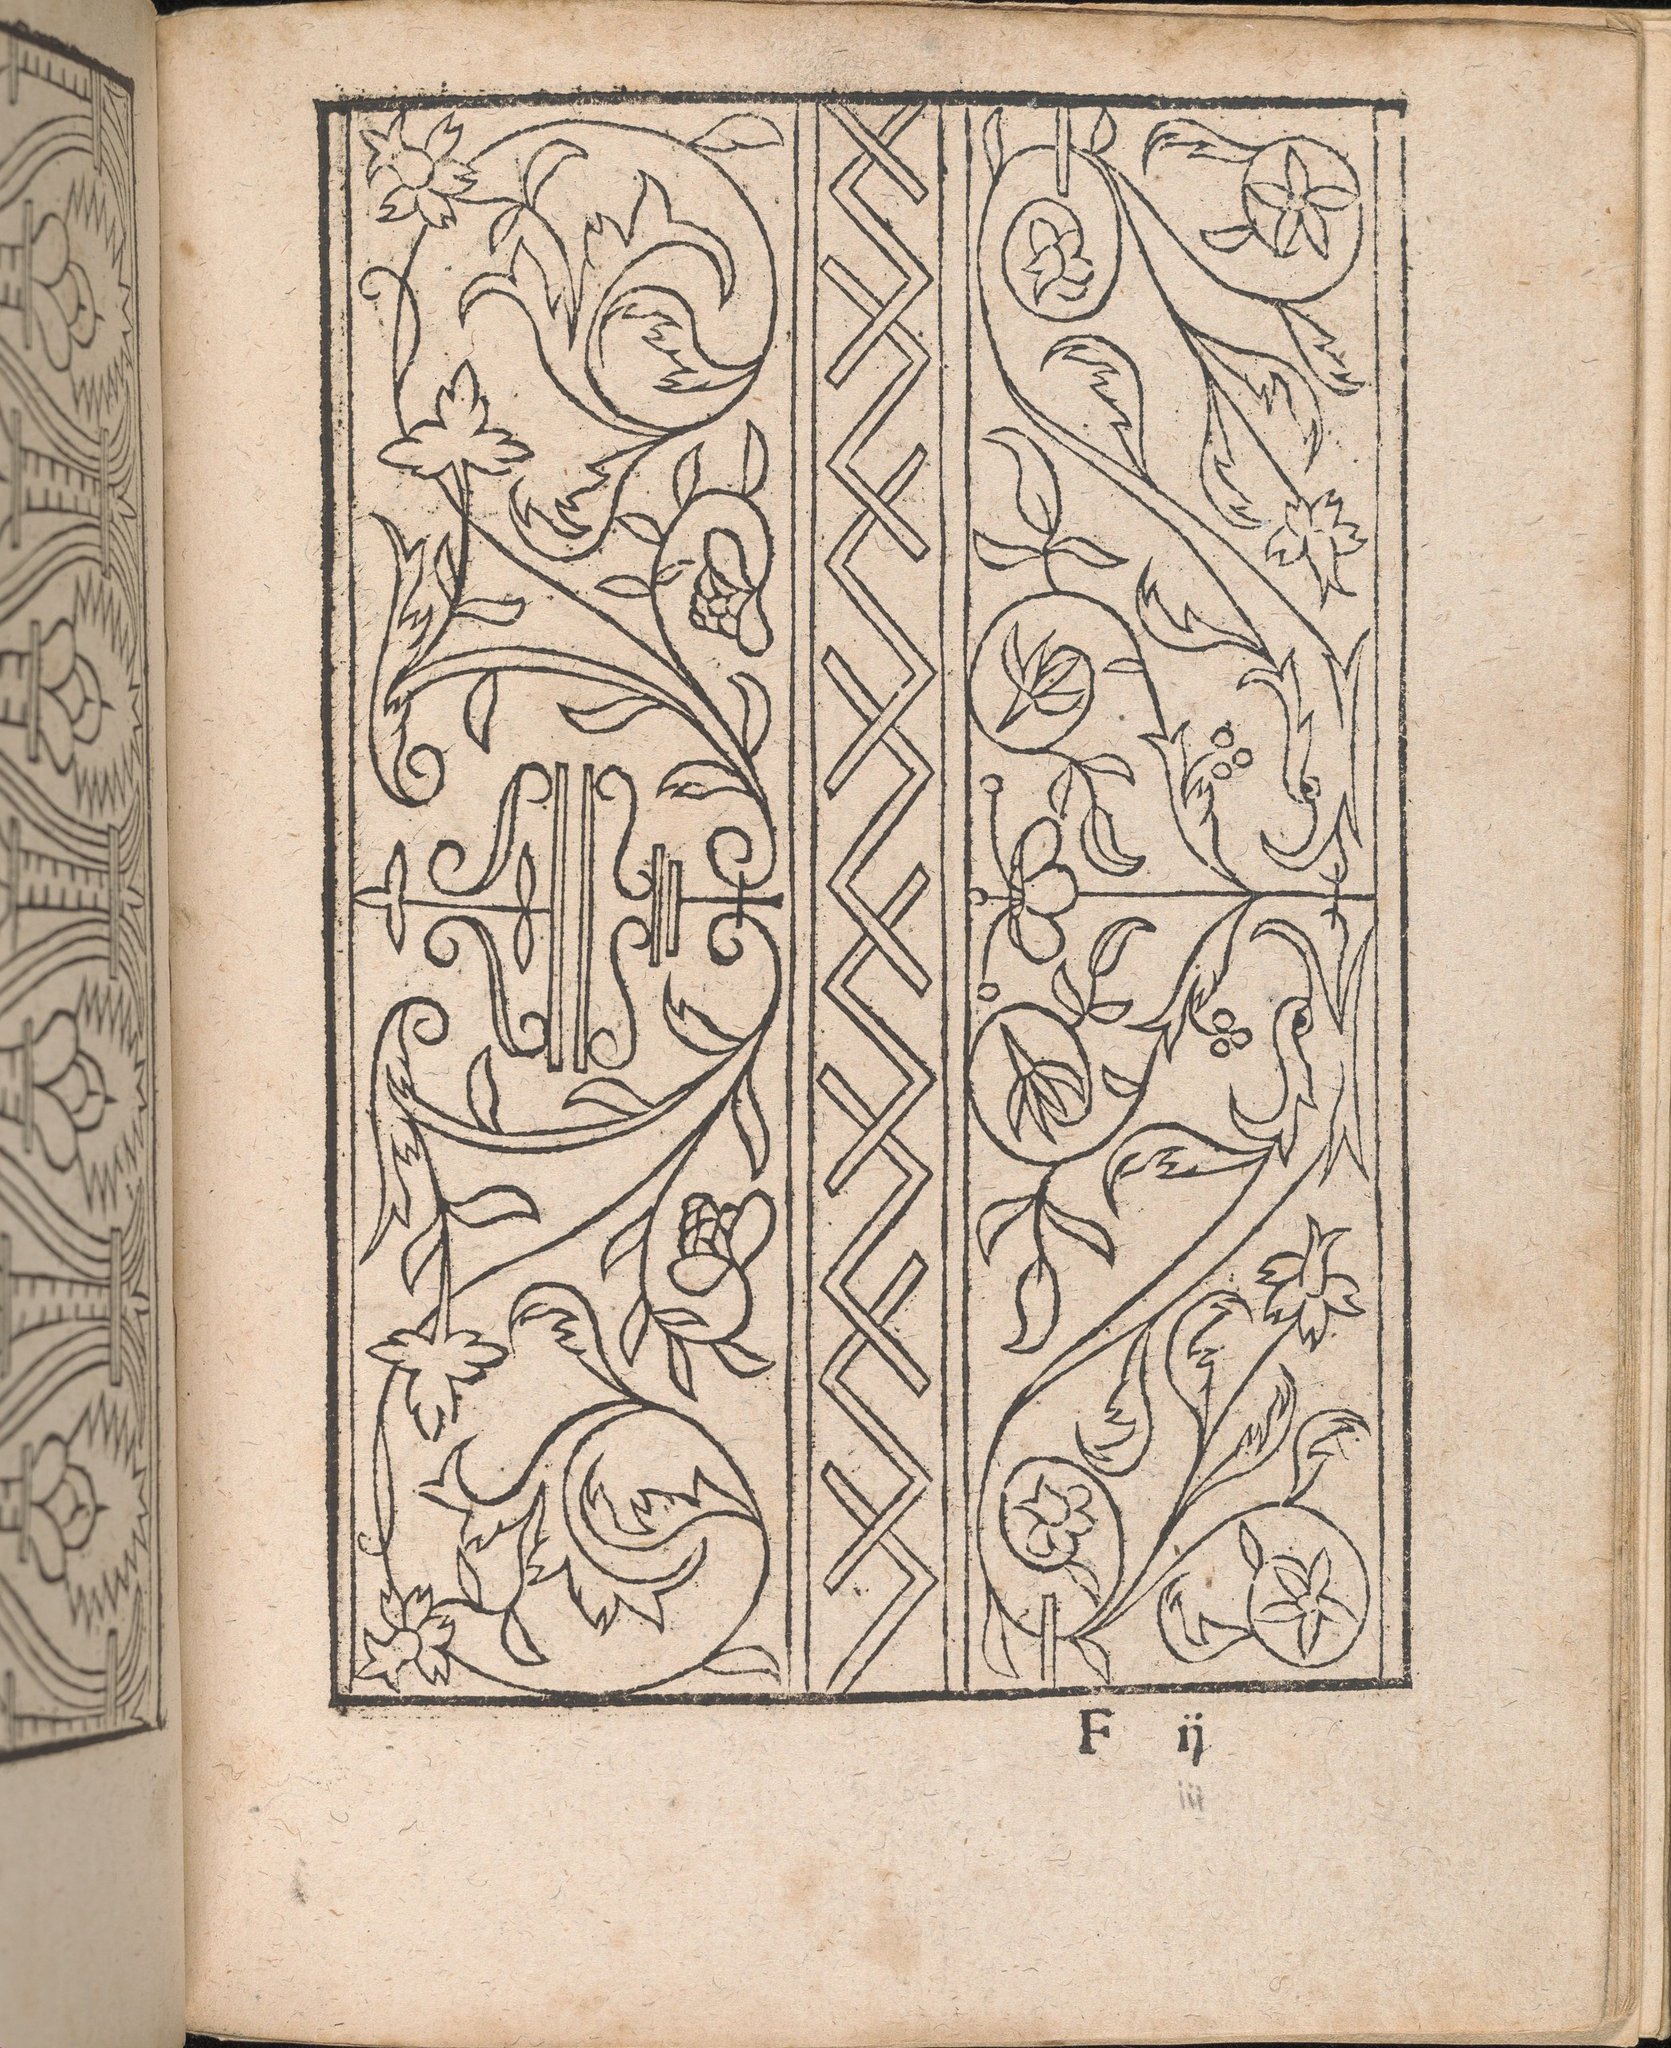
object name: book print ornament architecture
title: New Modelbüch allen Nägerin u. Sydenstickern (Page 23r)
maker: hans hoffman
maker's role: designer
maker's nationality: german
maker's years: 1556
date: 1556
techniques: woodcut